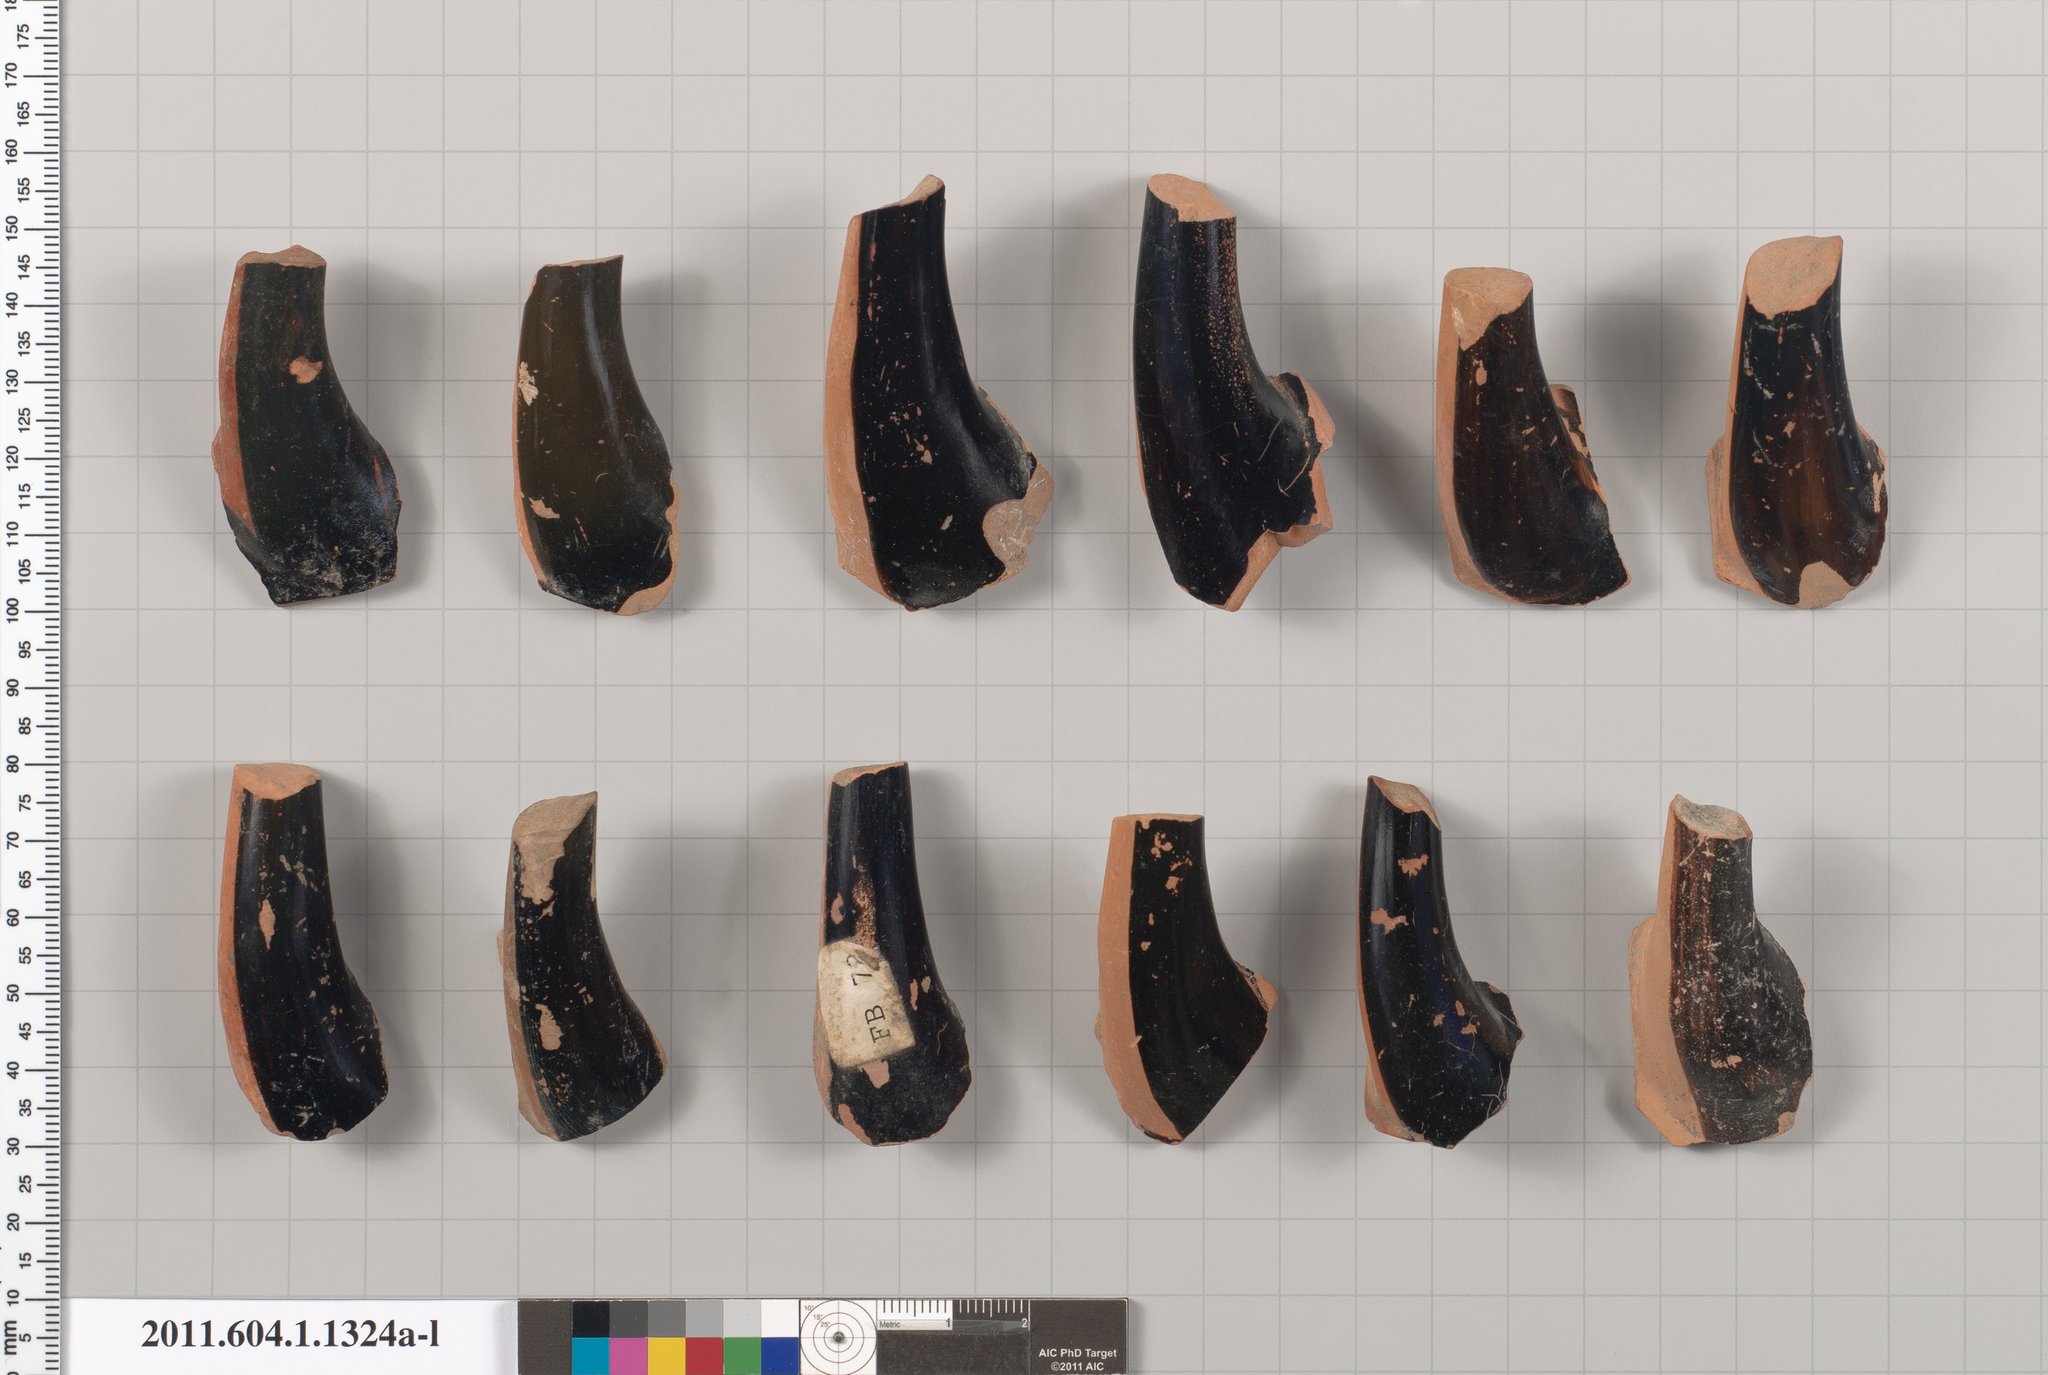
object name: kylix fragment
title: Terracotta fragments of kylikes (drinking cups)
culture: greek, attic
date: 500-401 BCE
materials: terracotta